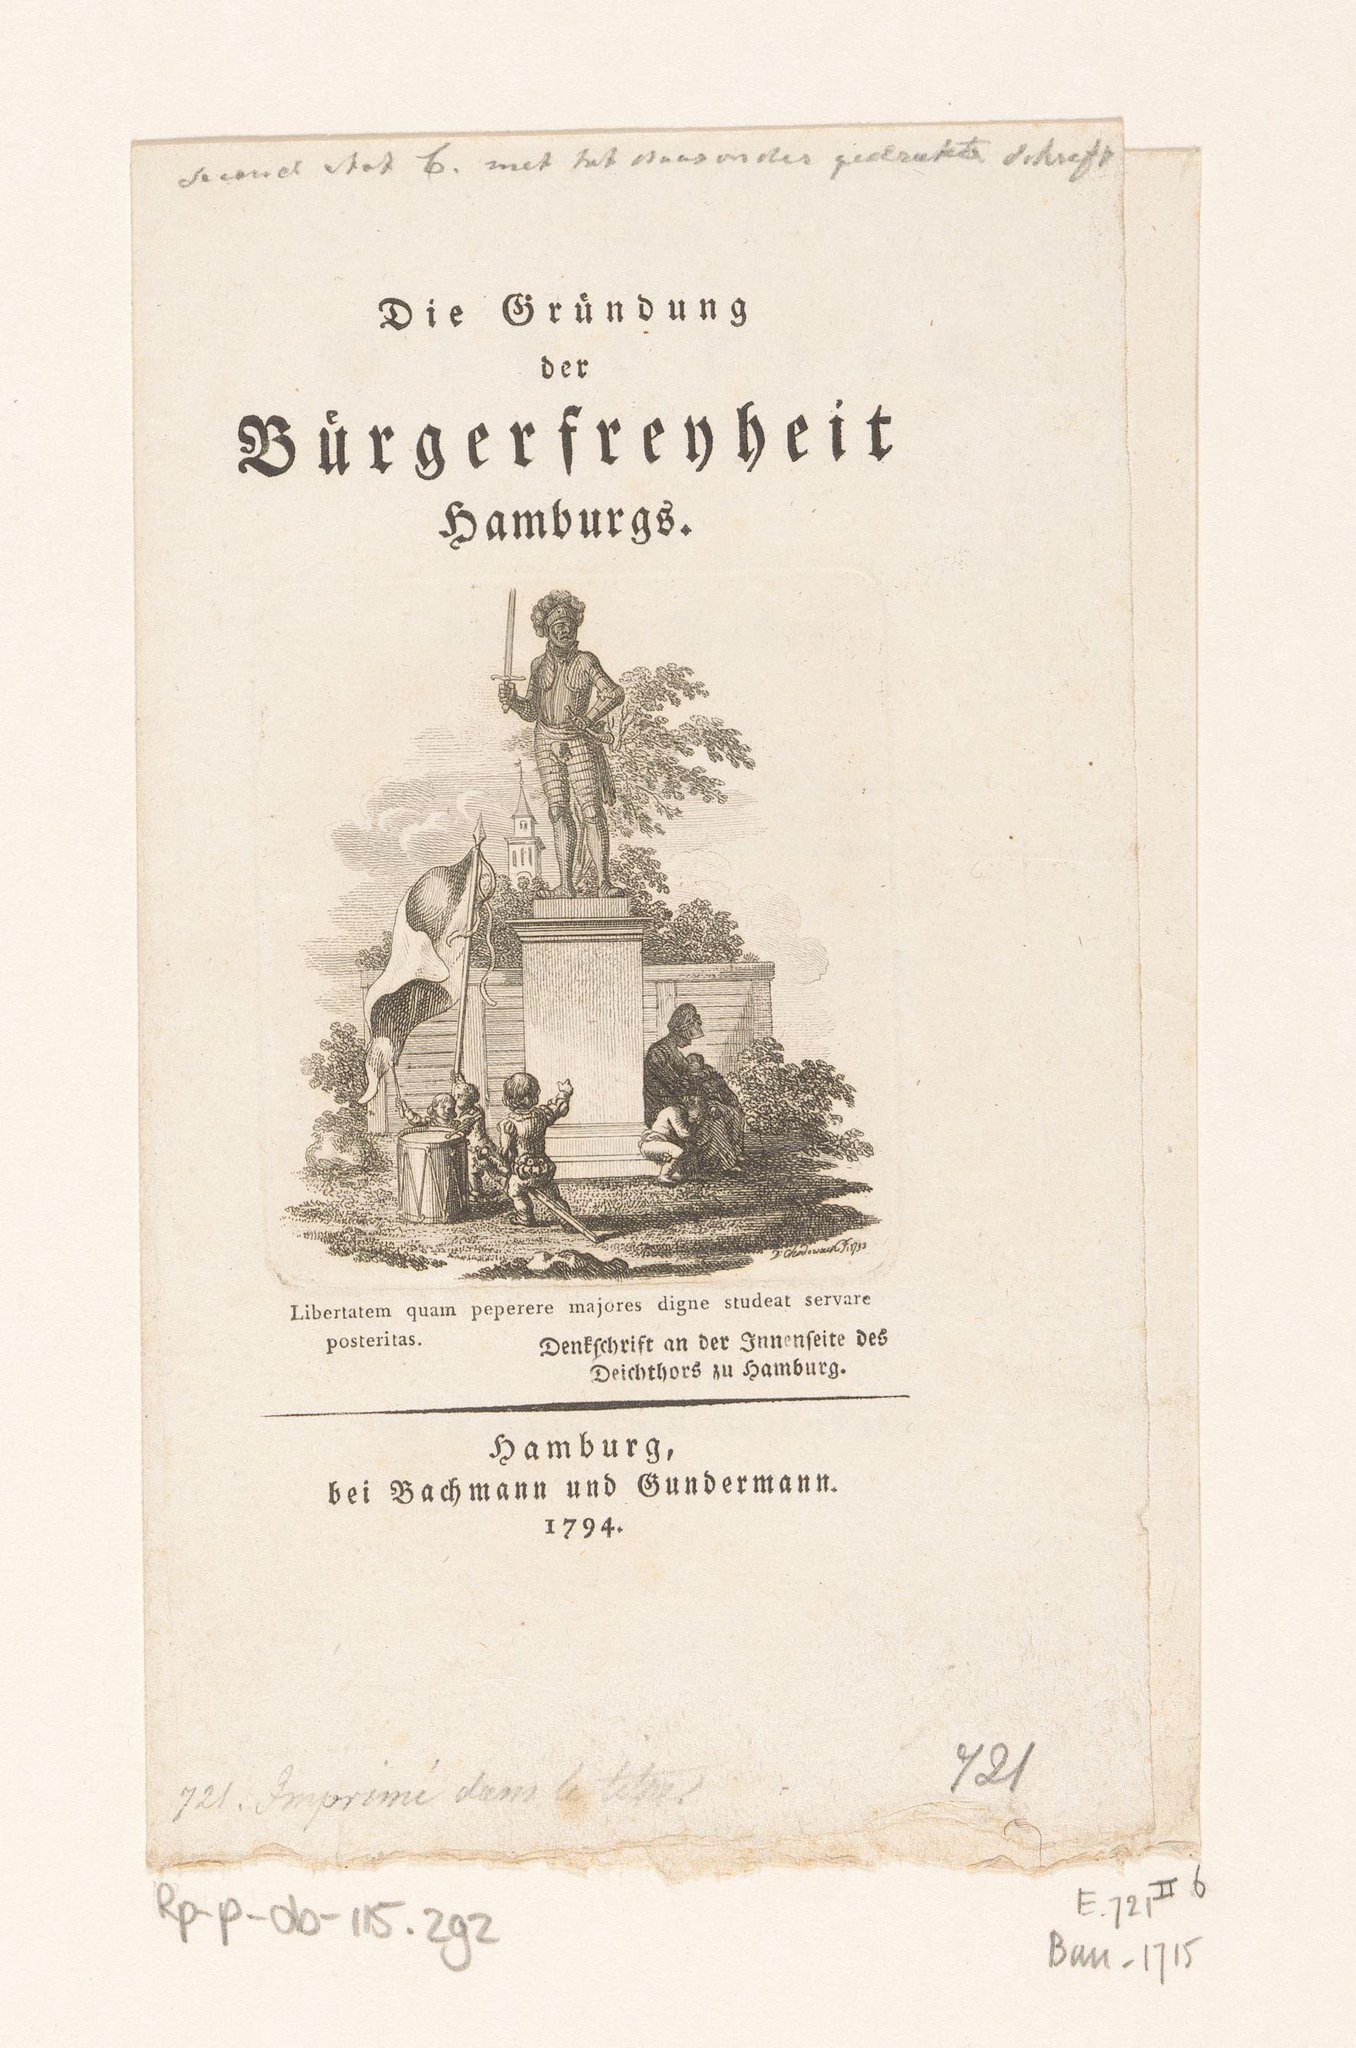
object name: print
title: Titelpagina voor: Leonhard Wächter, Die Gründung der Bügerfreyheit Hamburgs, 1794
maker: daniel nikolaus chodowiecki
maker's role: draughtsman, print maker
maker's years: 1726-1801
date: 1793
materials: paper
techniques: etching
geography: hamburg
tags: riding a horse, ass, or mule; rider, horseman, breasts giving milk, roland, monument, statue, drum (musical instrument) - cc - out of doors, flag, colours (as symbol of the state, etc.)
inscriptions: collector's mark: Lugt 2228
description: Prent gebruikt voor: Wächter, Leonhard. Die Gründung der Bügerfreyheit Hamburgs. Hamburg: Bachmann und Gundermann, 1794, dl. 1.